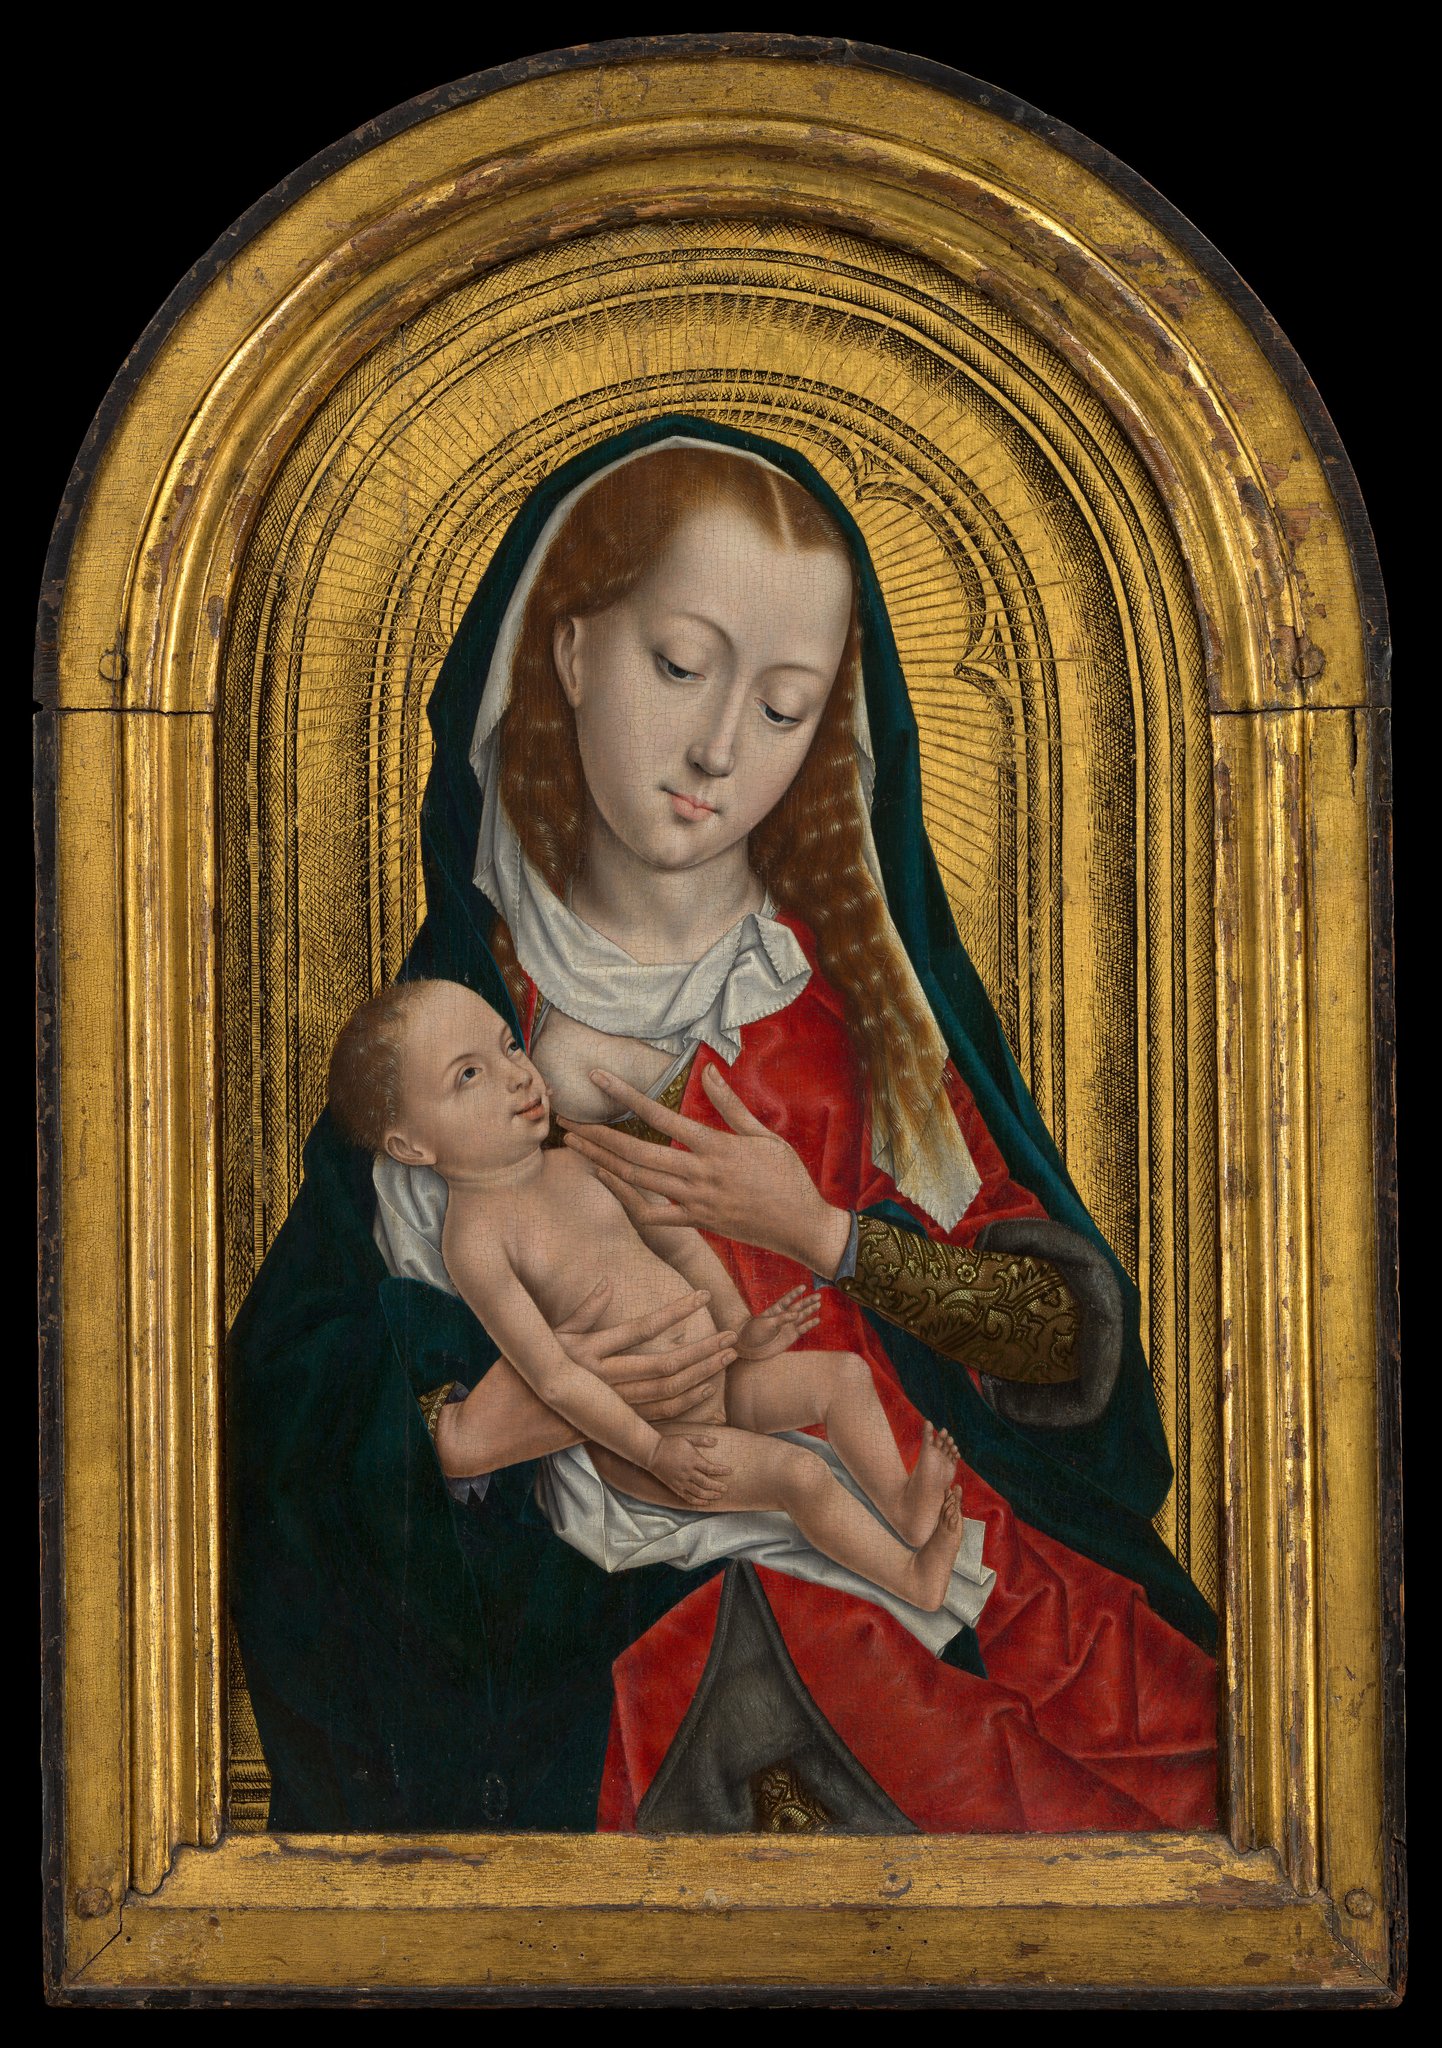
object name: painting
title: Virgin and Child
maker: follower of rogier van der weyden (master of the saint ursula legend group, netherlandish, active late 15th century)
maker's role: artist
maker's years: 1470-1499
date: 1480-1490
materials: oil, wood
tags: madonna and child,nursing